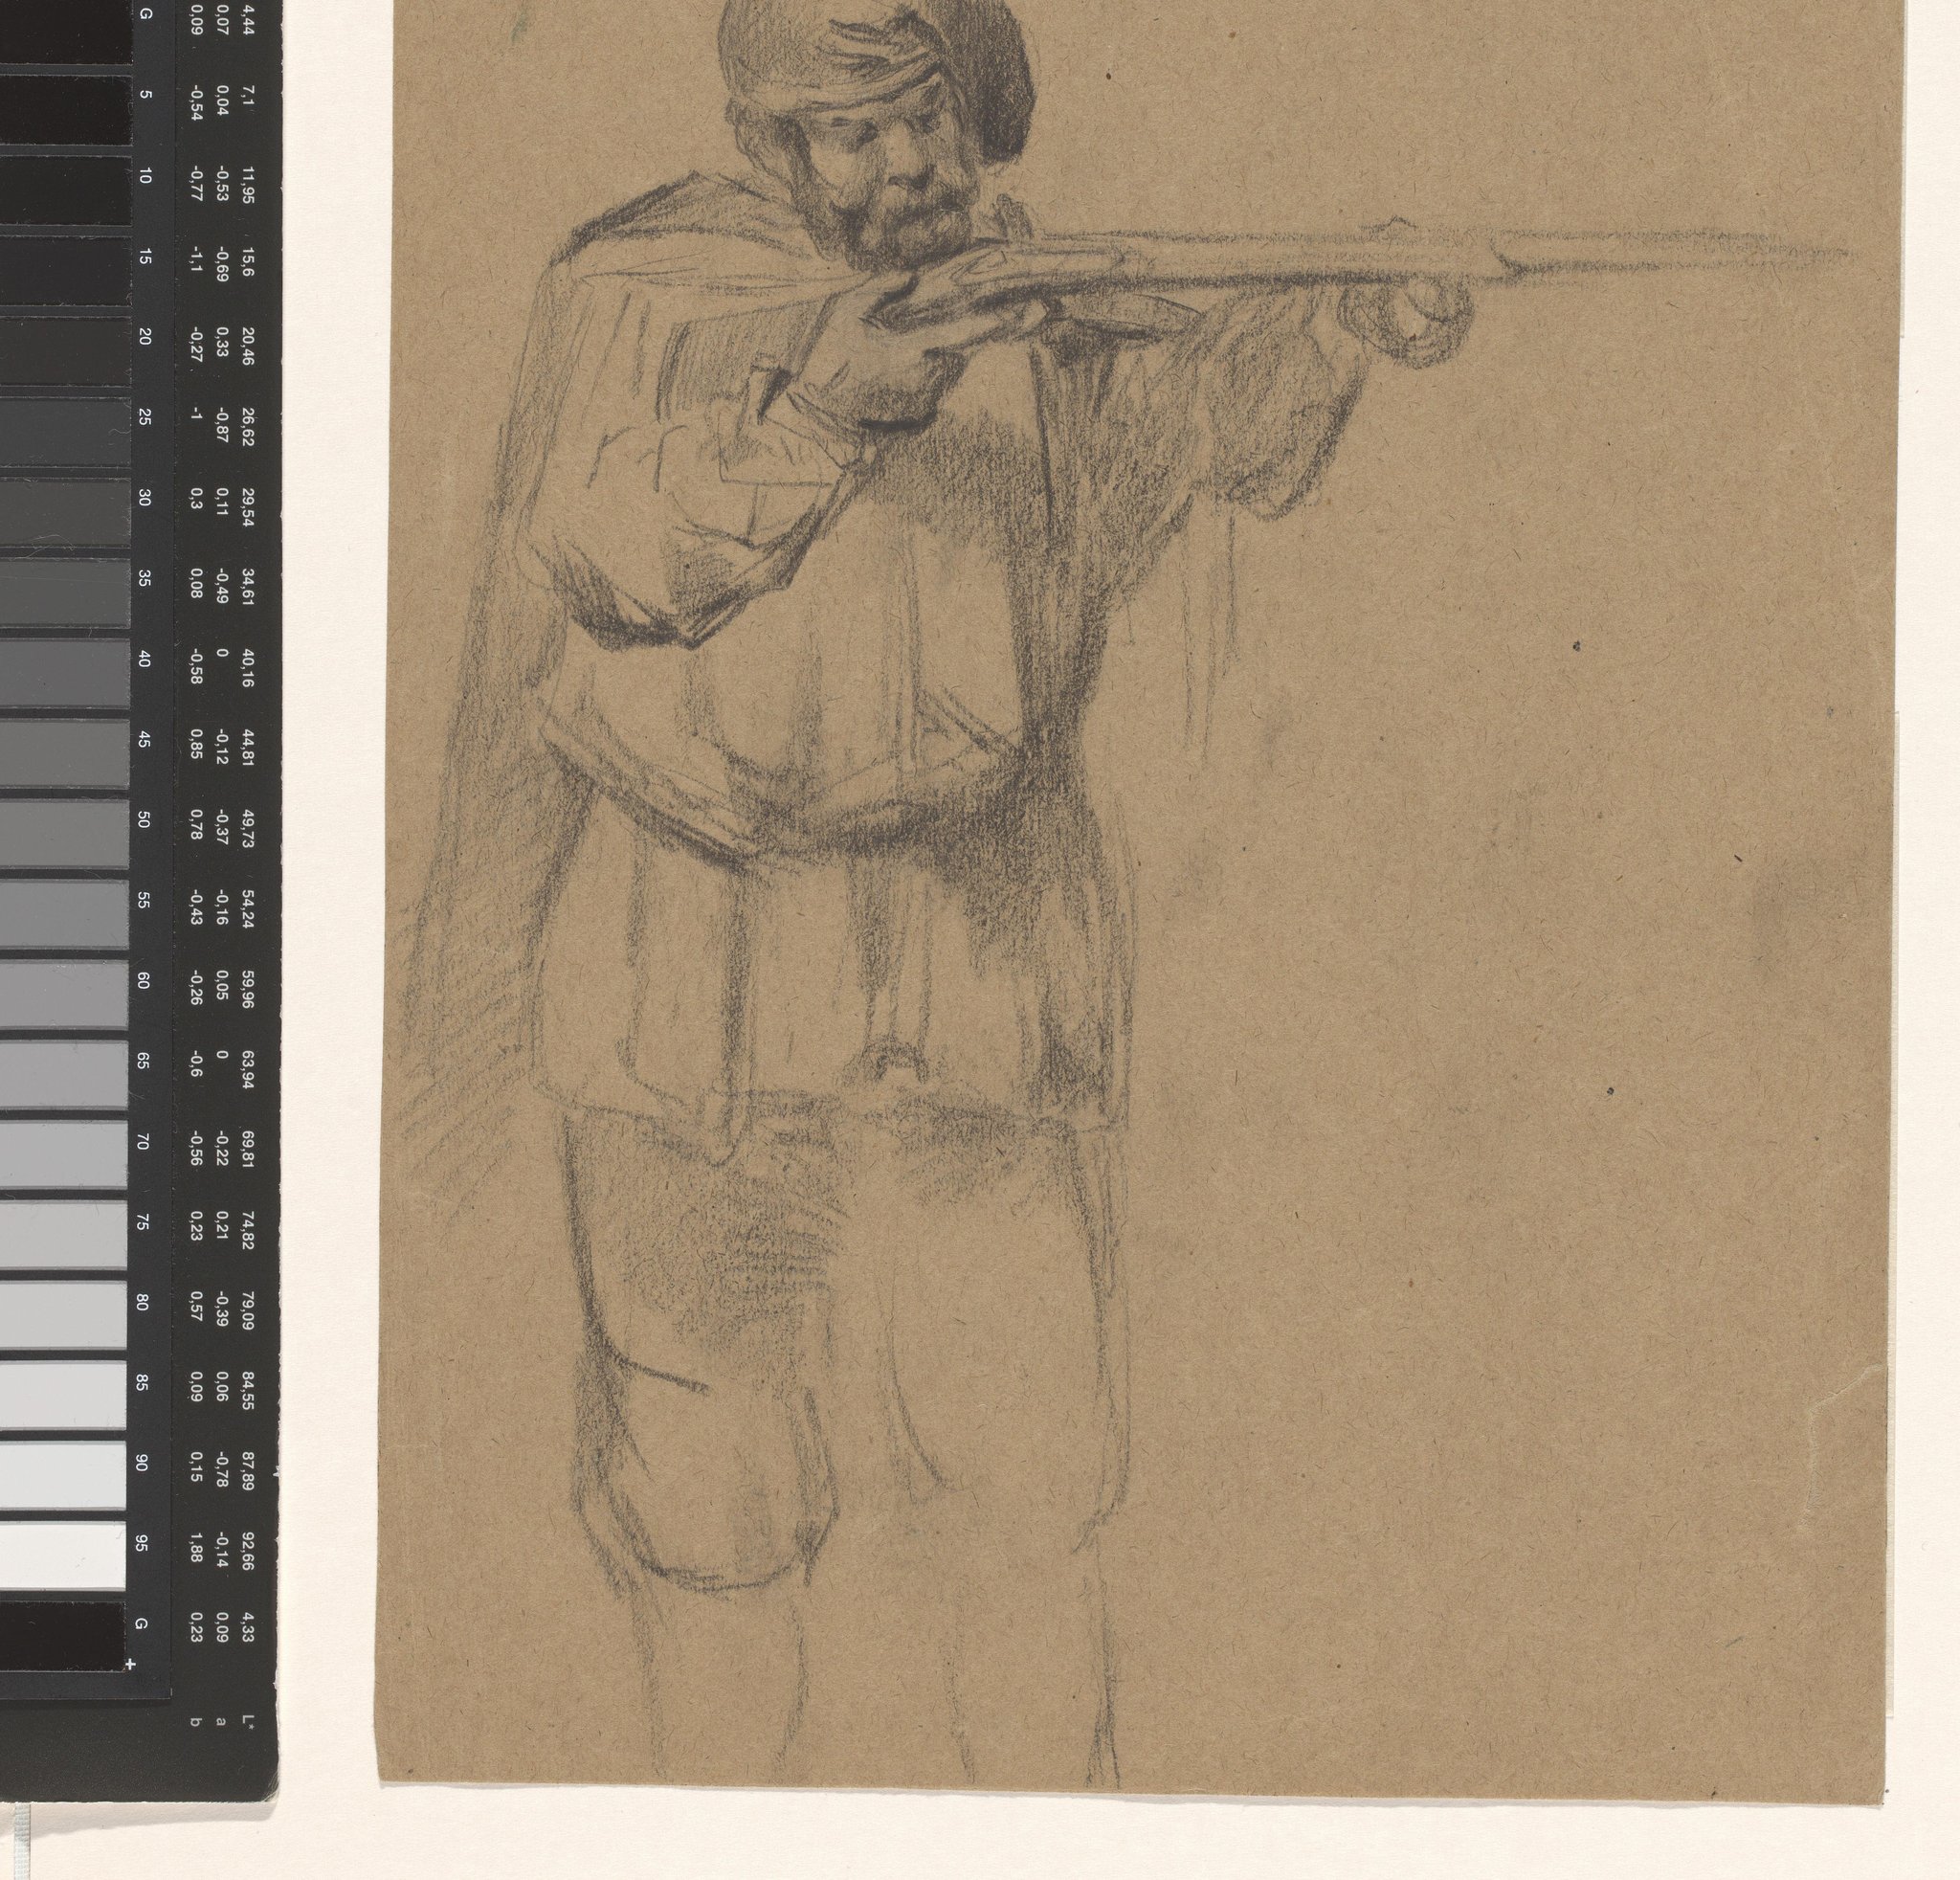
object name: drawing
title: Staande man met muts en geweer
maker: jan bedijs tom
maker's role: draughtsman, painter, print maker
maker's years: 1813-1894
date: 1823-1894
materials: paper, pencil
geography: the hague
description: Man houdt het geweer paraat op ooghoogte